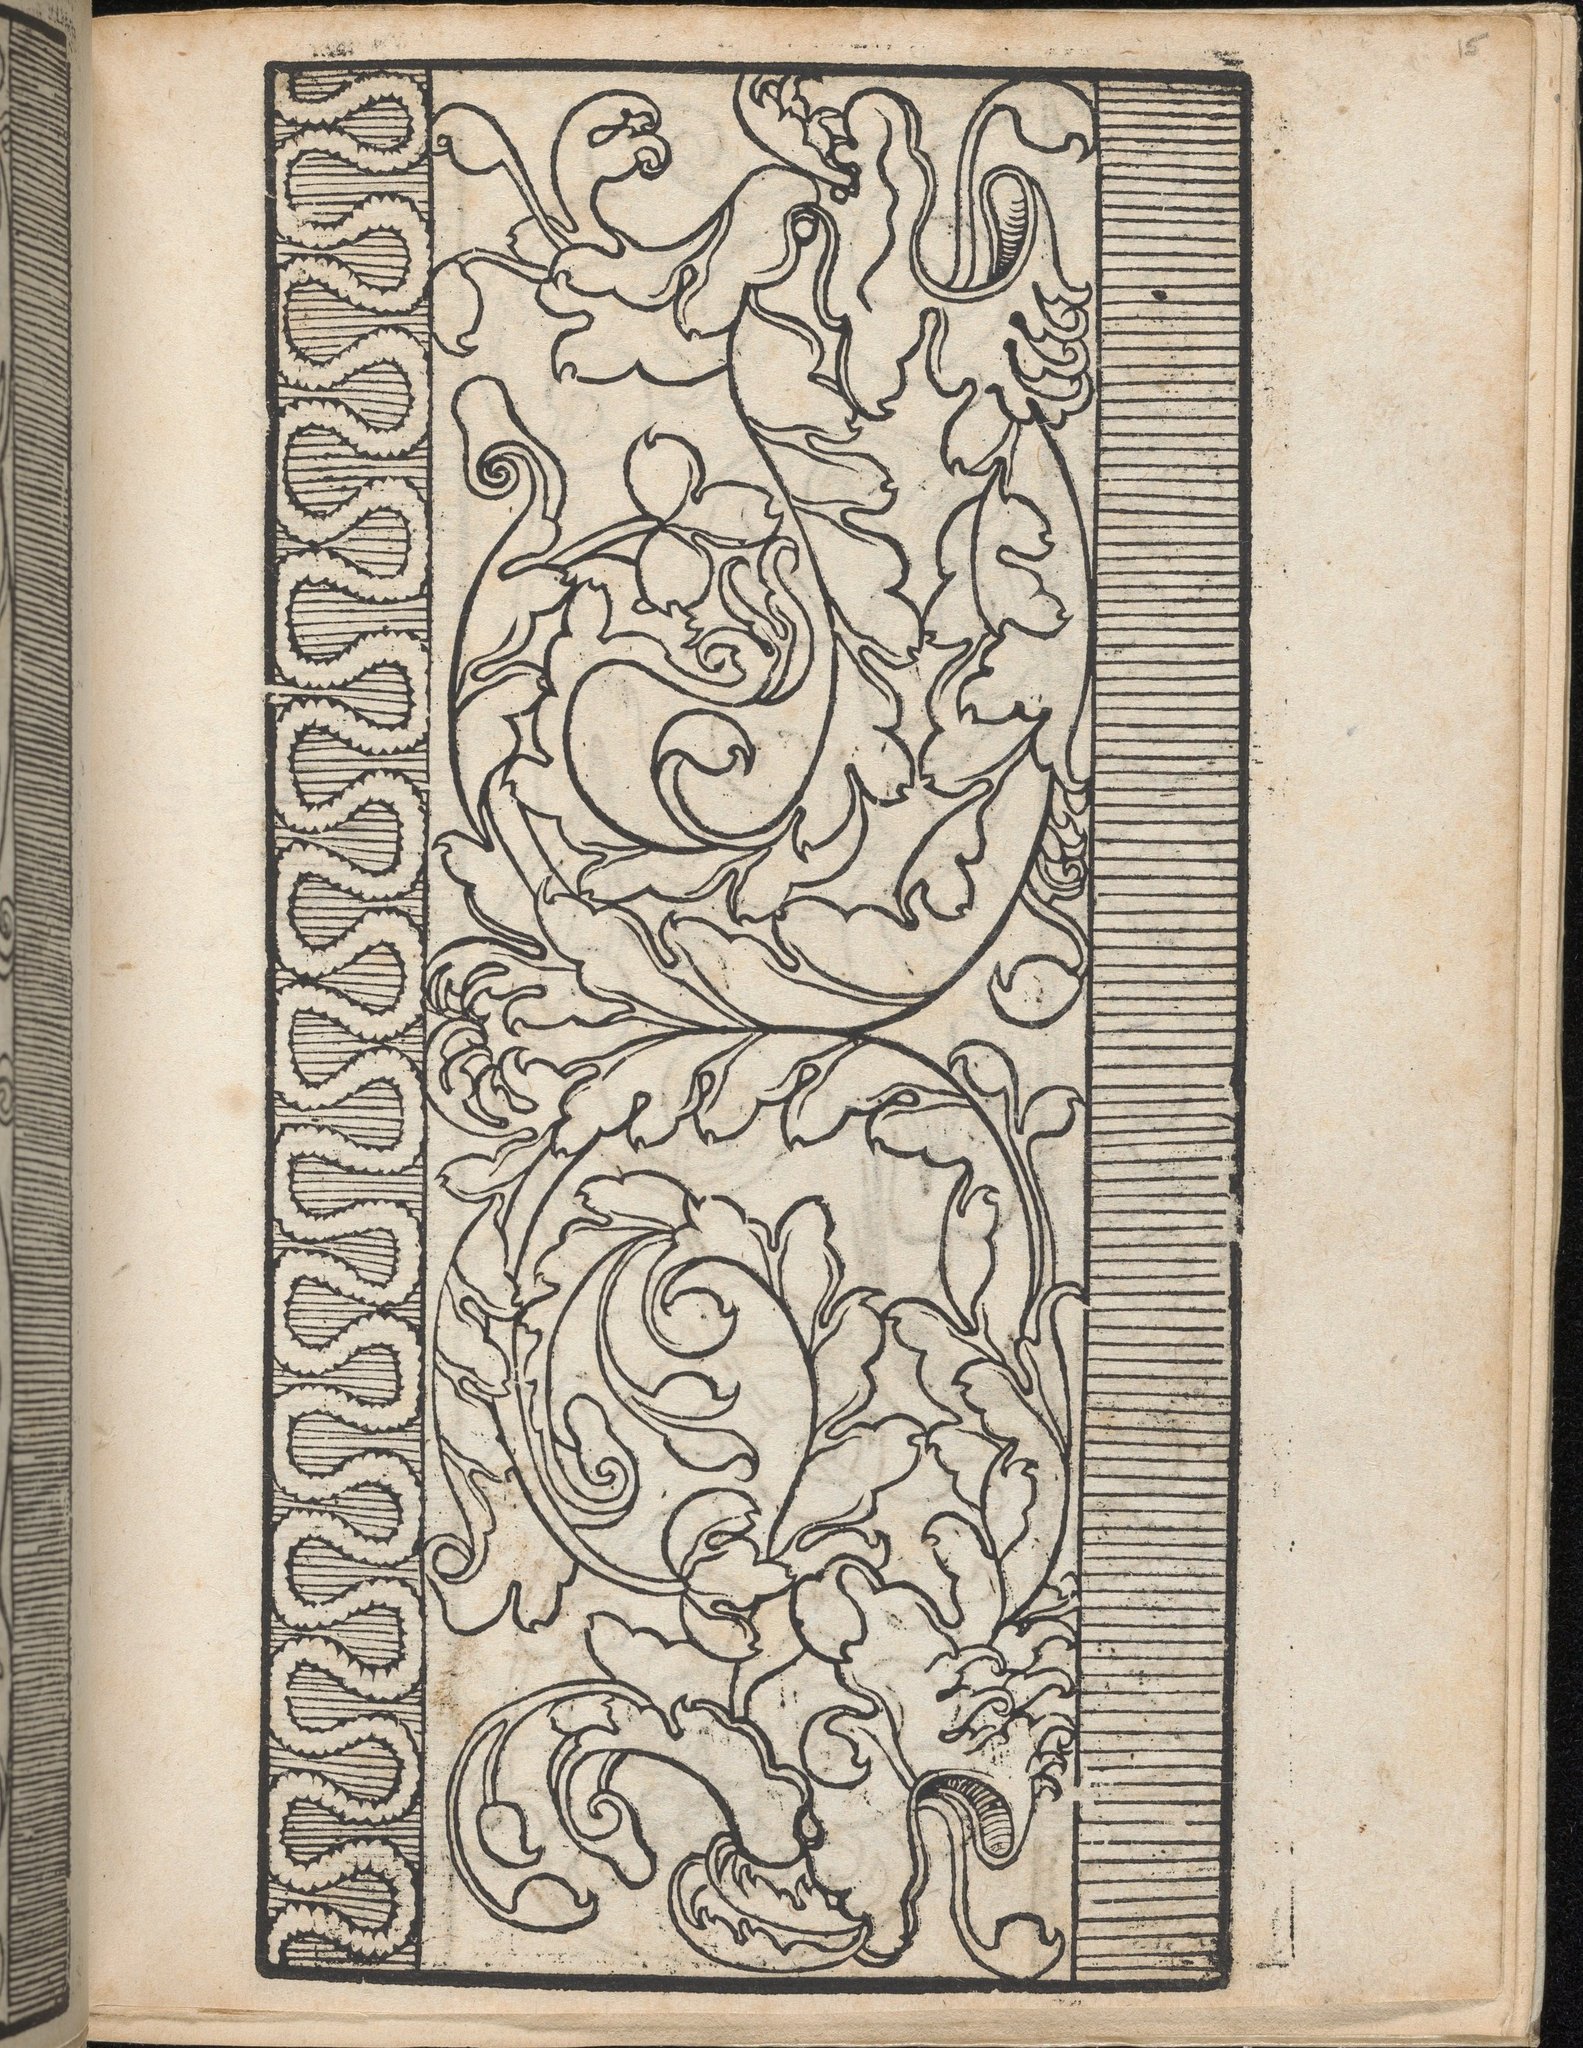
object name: book print ornament architecture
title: Ein new Modelbuch..., page 8 (recto)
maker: johann schönsperger the younger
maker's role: publisher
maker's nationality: german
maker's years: 1490-1550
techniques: woodcut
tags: acorns